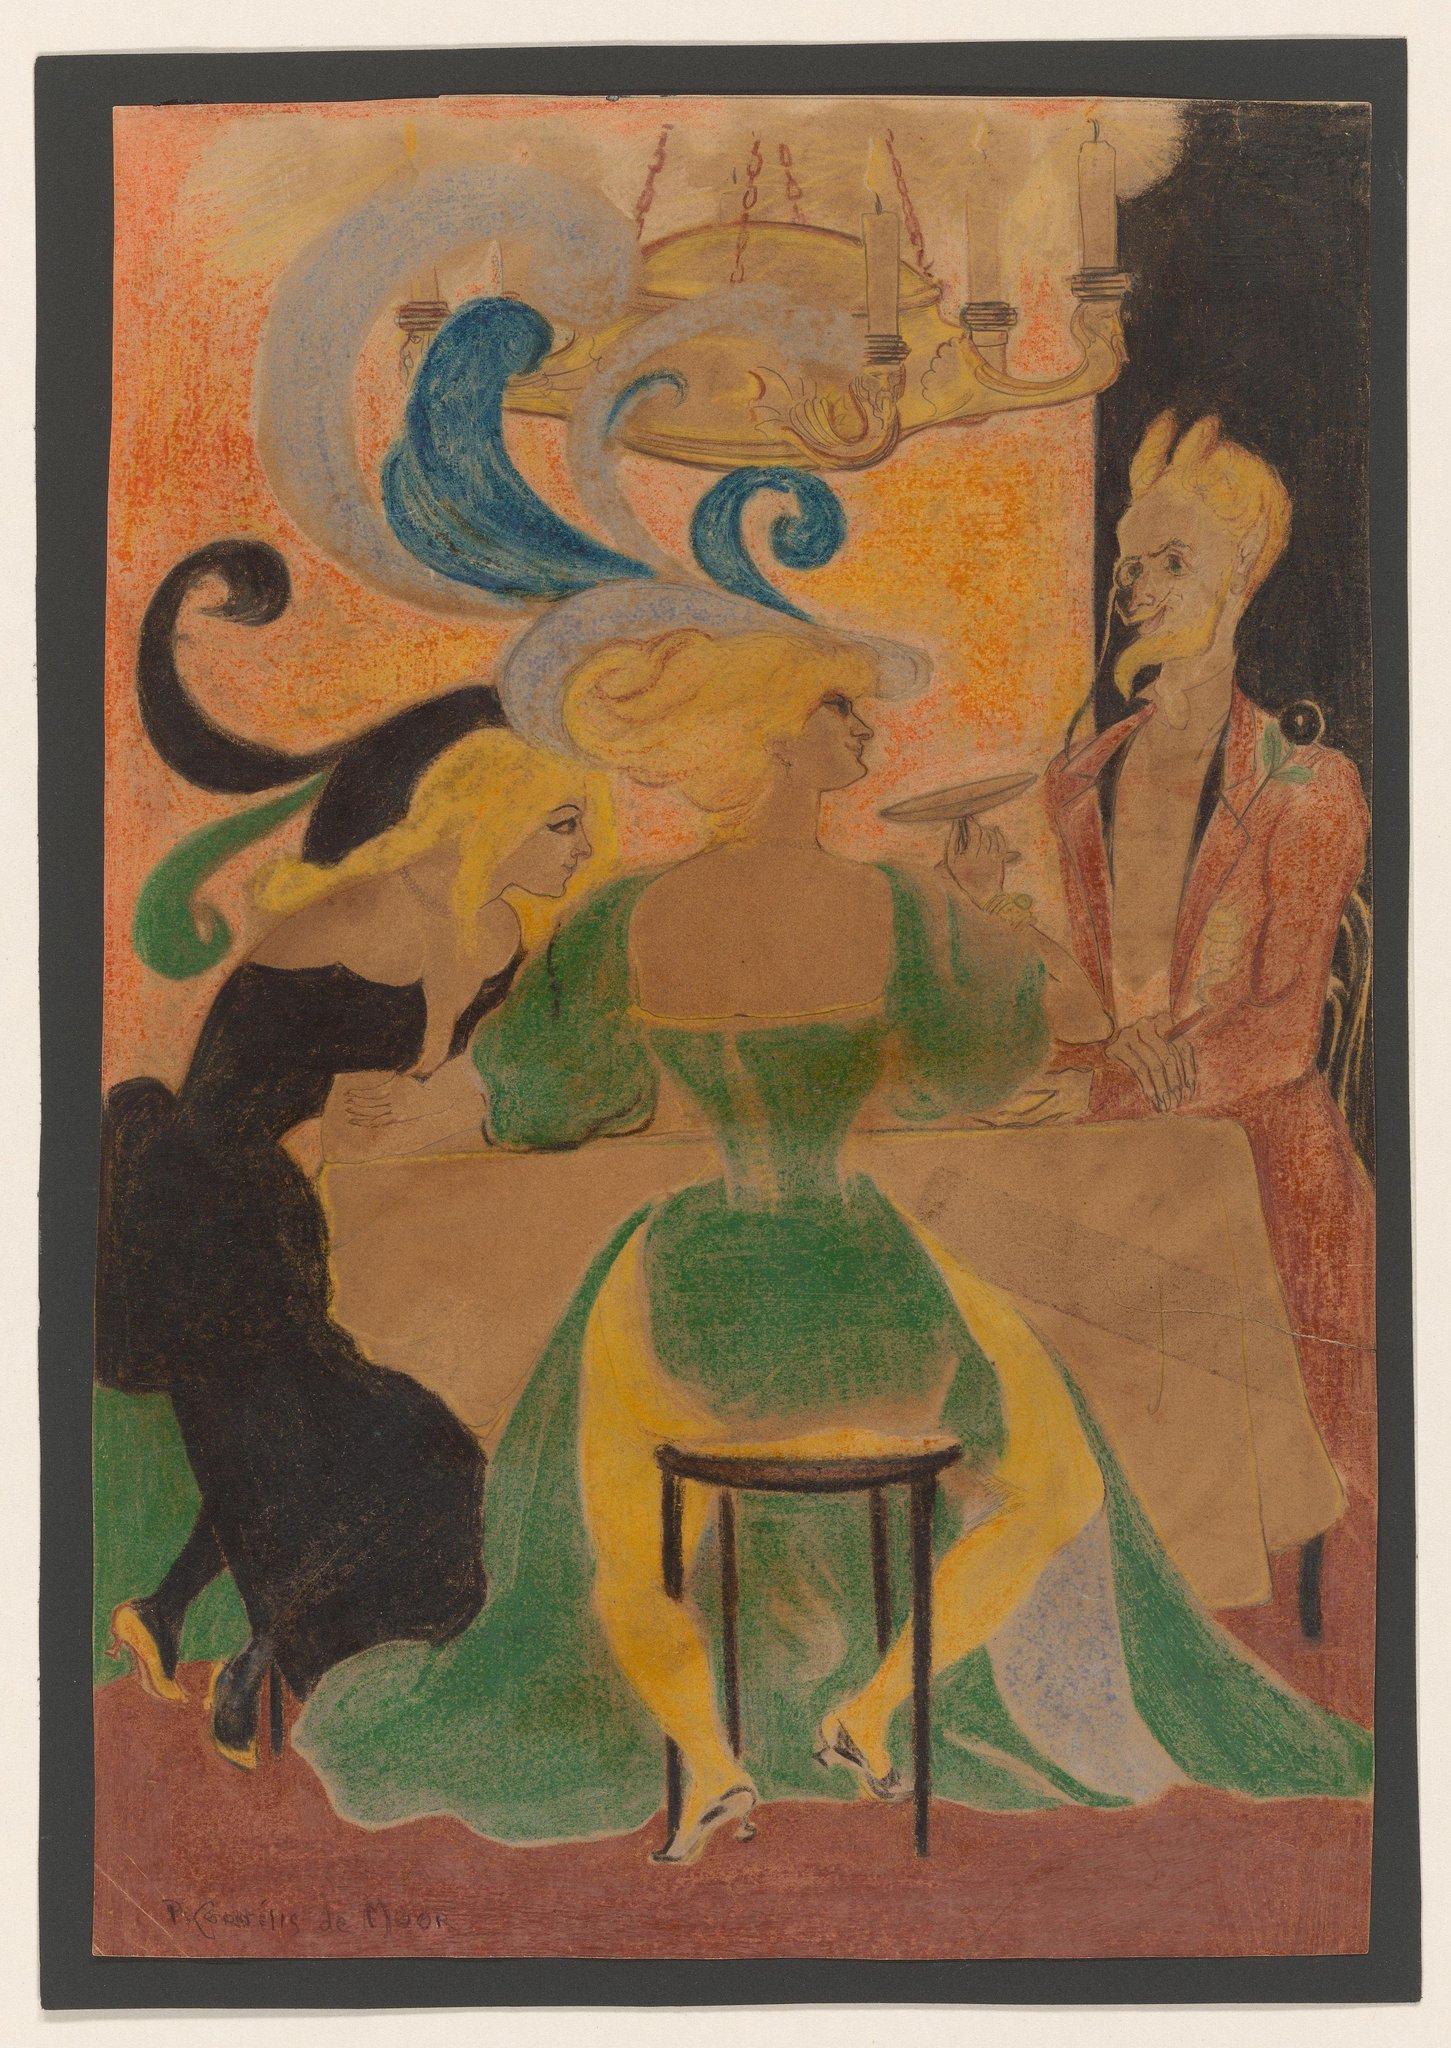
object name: drawing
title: Grotesque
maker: pieter cornelis de moor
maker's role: draughtsman, print maker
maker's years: 1866-1953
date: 1876-1953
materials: paper, pencil